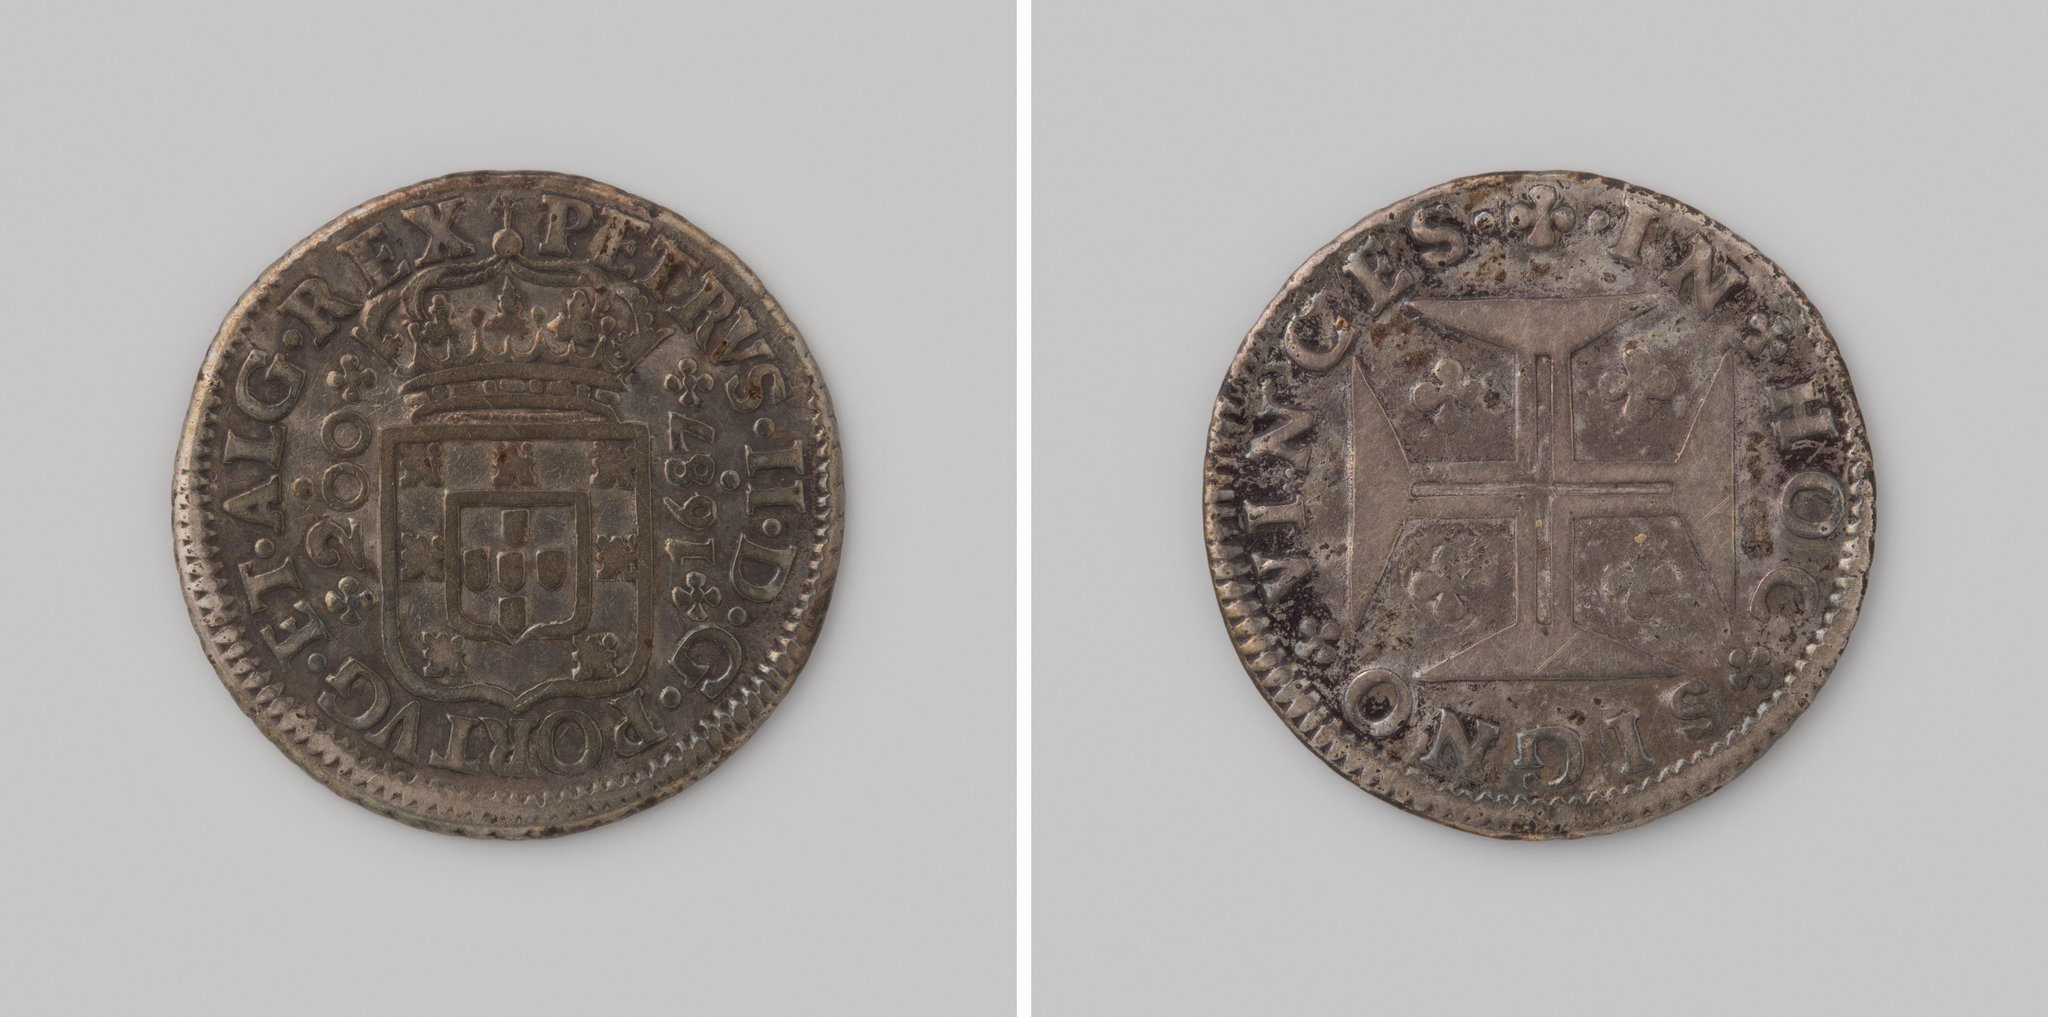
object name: coin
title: Portugal, koning Pedro II, ½ cruzado of 200 reis, 1687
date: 1687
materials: silver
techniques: striking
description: Zilveren munt. Voorzijde: gekroond wapenschild, links daarvan waarde-aanduiding: 200, rechts daarvan jaartal. Keerzijde: kort gevoet kruis, met in de hoeken kruisjes. Kabelrand.